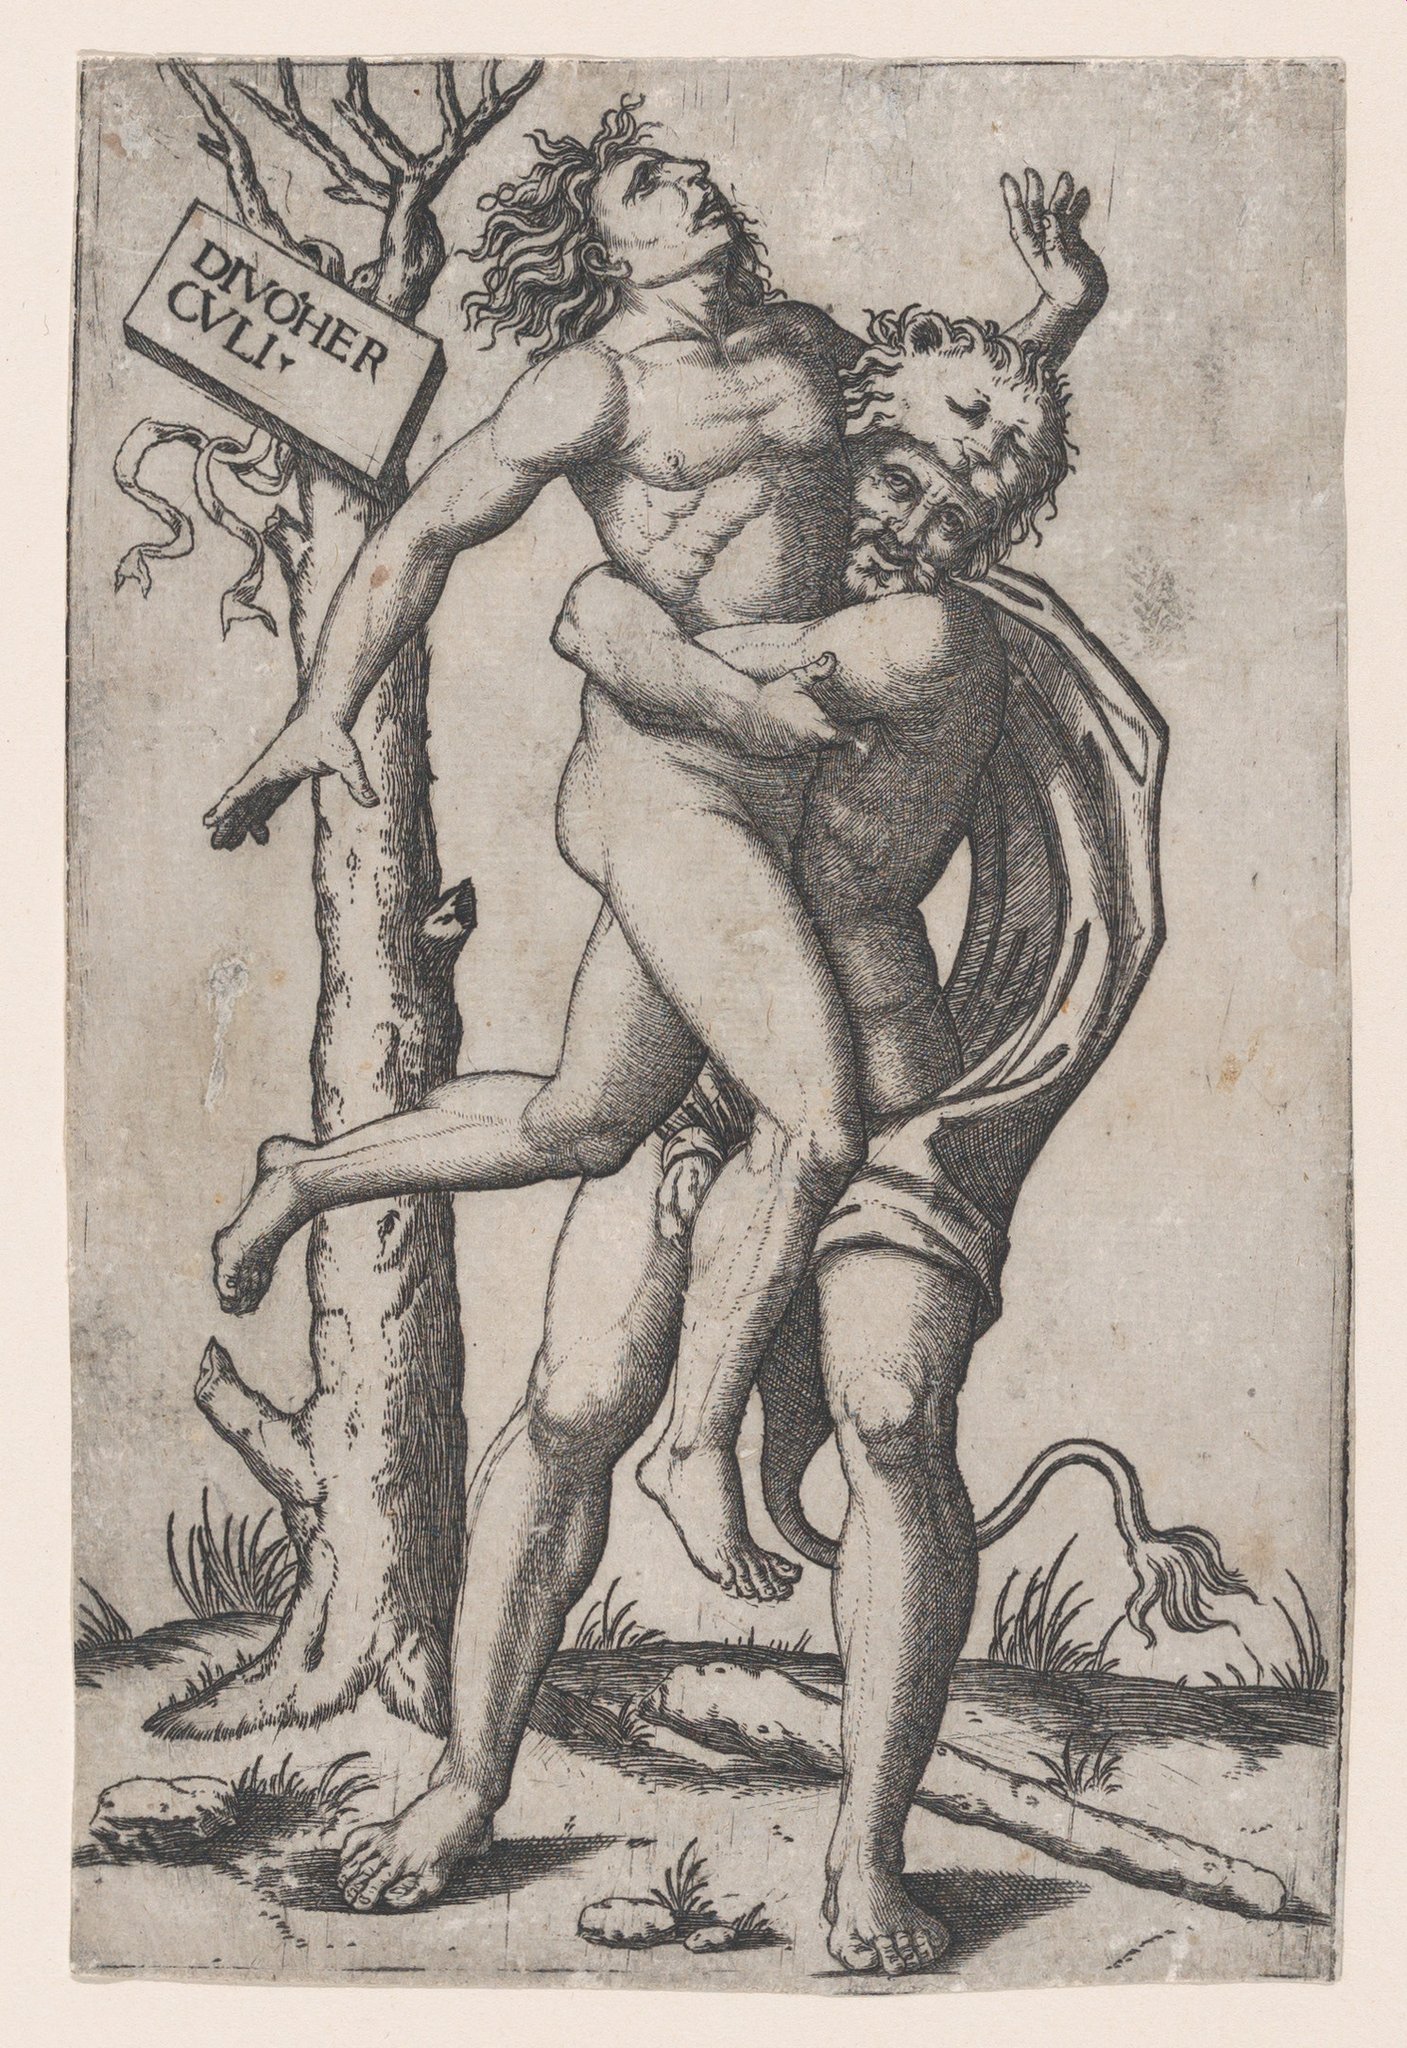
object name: print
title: Hercules, grasping Antaeus at the waist with both arms and lifting him off his feet, in background at right the ruins of a temple, at left a group of trees against which are posed a club and the skin of a lion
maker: marcantonio raimondi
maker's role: artist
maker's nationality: italian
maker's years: 1475-1534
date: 1500-1550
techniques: engraving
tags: hercules,trees